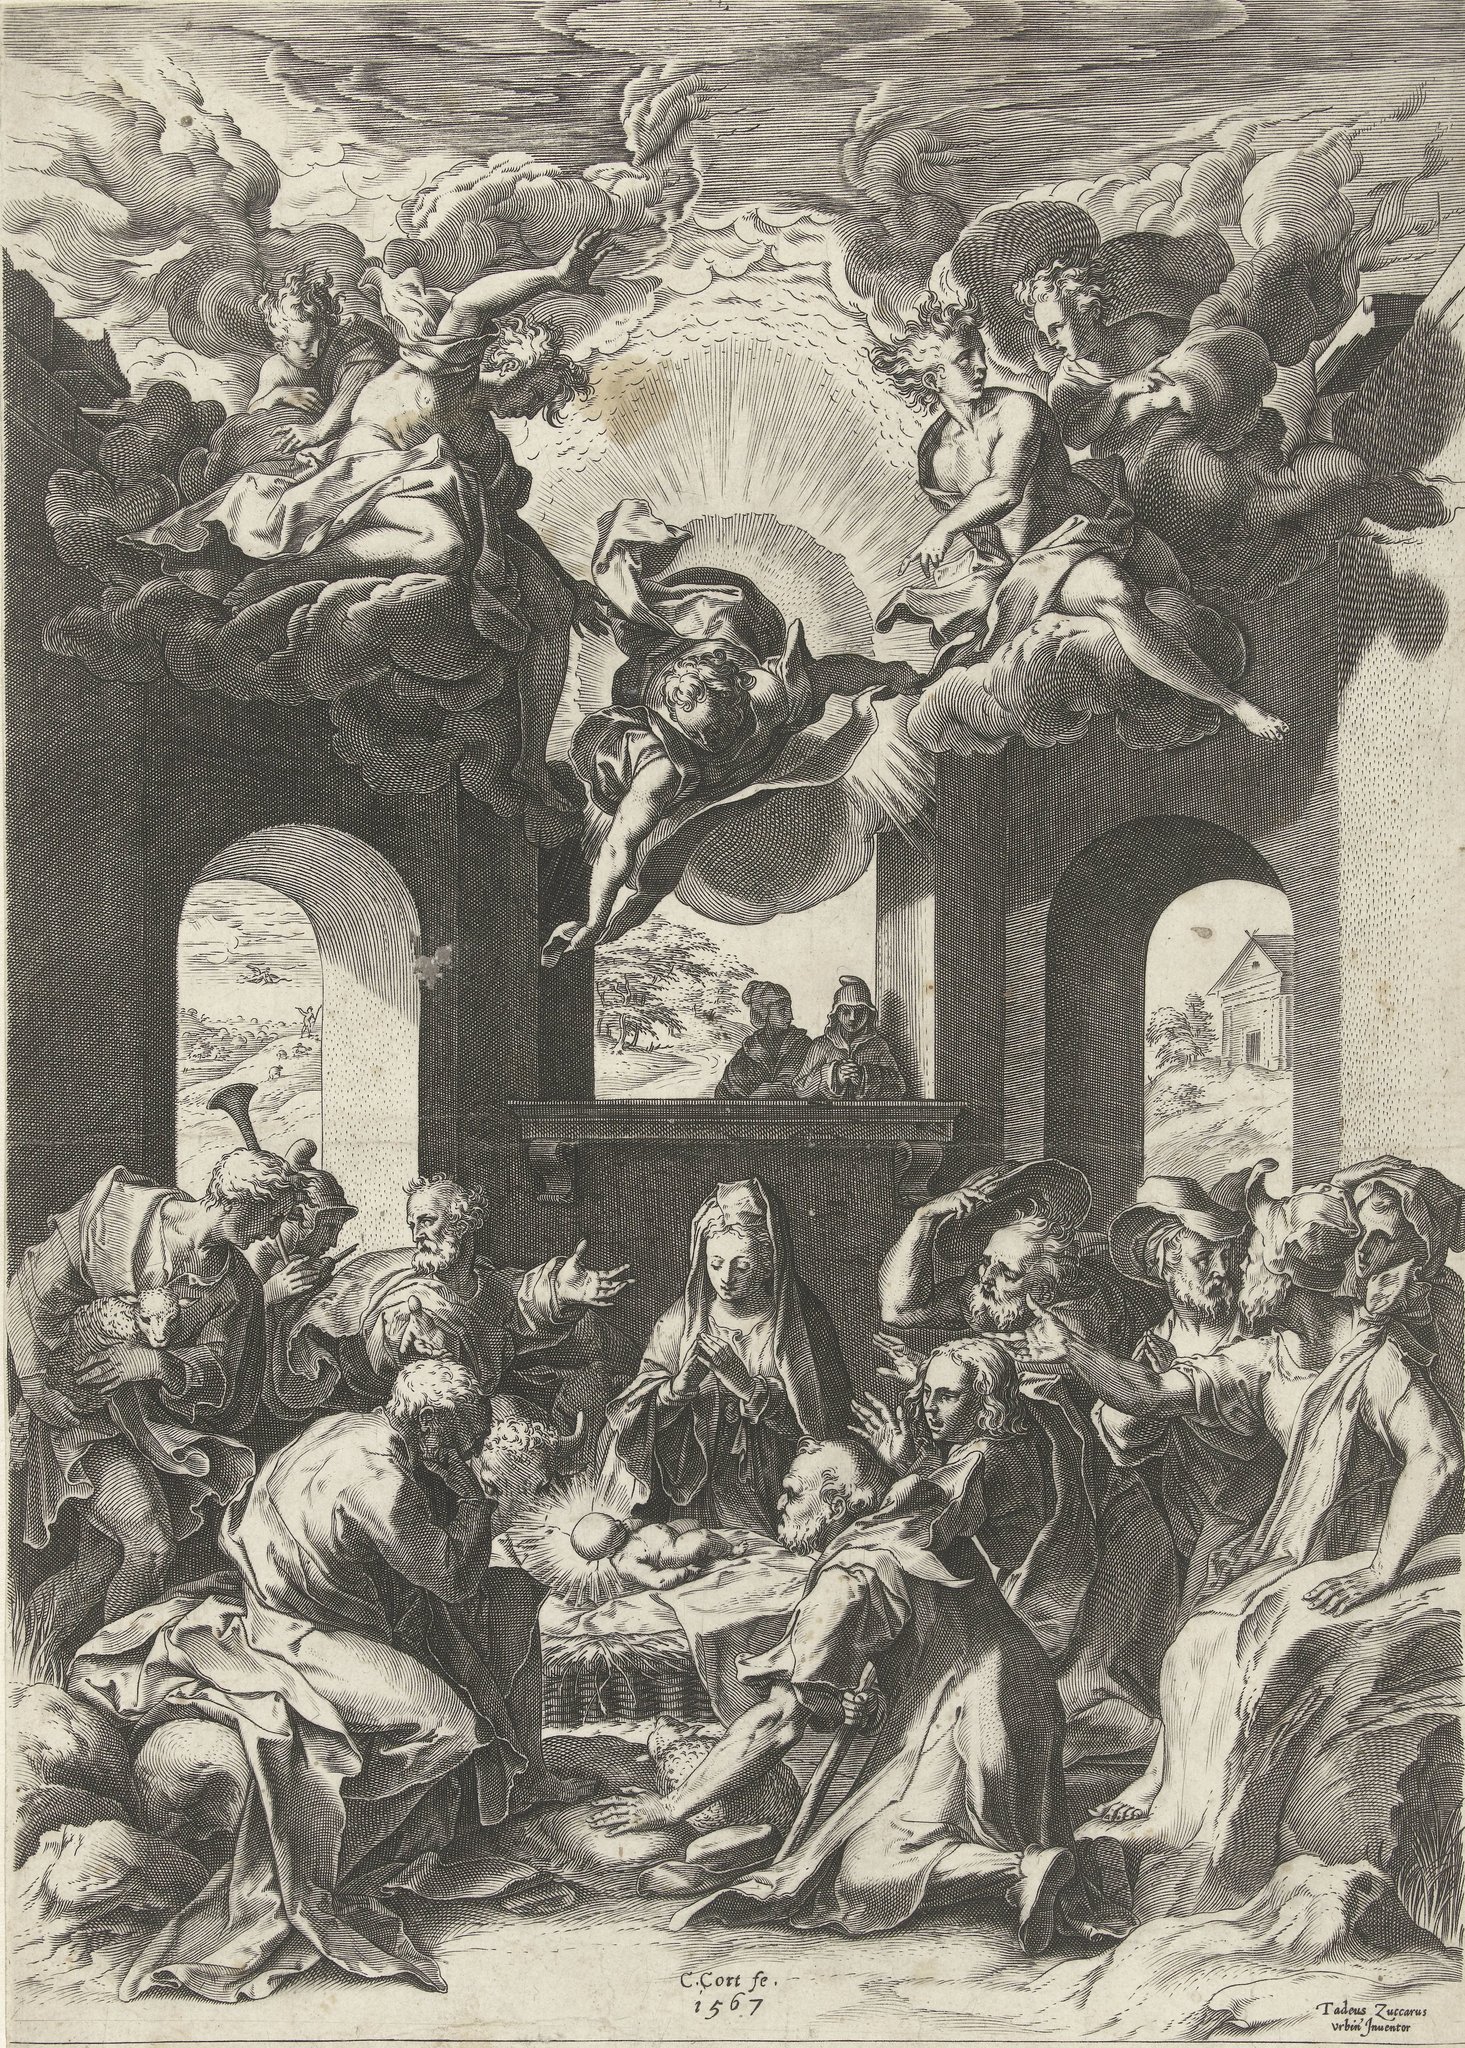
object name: print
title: Aanbidding door de herders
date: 1567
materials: paper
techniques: engraving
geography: rome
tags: adoration of the christ-child by the shepherds; mary and joseph present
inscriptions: signature: ‘C. Cort fe’, address: ‘Tadeus Zuccarus / urbin Inventor’, collector's mark: Lugt 2228, date: ‘1567’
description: In een ruimte met boogvormige ingangen zit Maria, in het midden, geknield voor het Kind. Eromheen een grote groep herders. Boven hen een engel met banderol in de handen, omgeven door andere engelen in een wolk. Twee vrouwen kijken toe door een open venster.